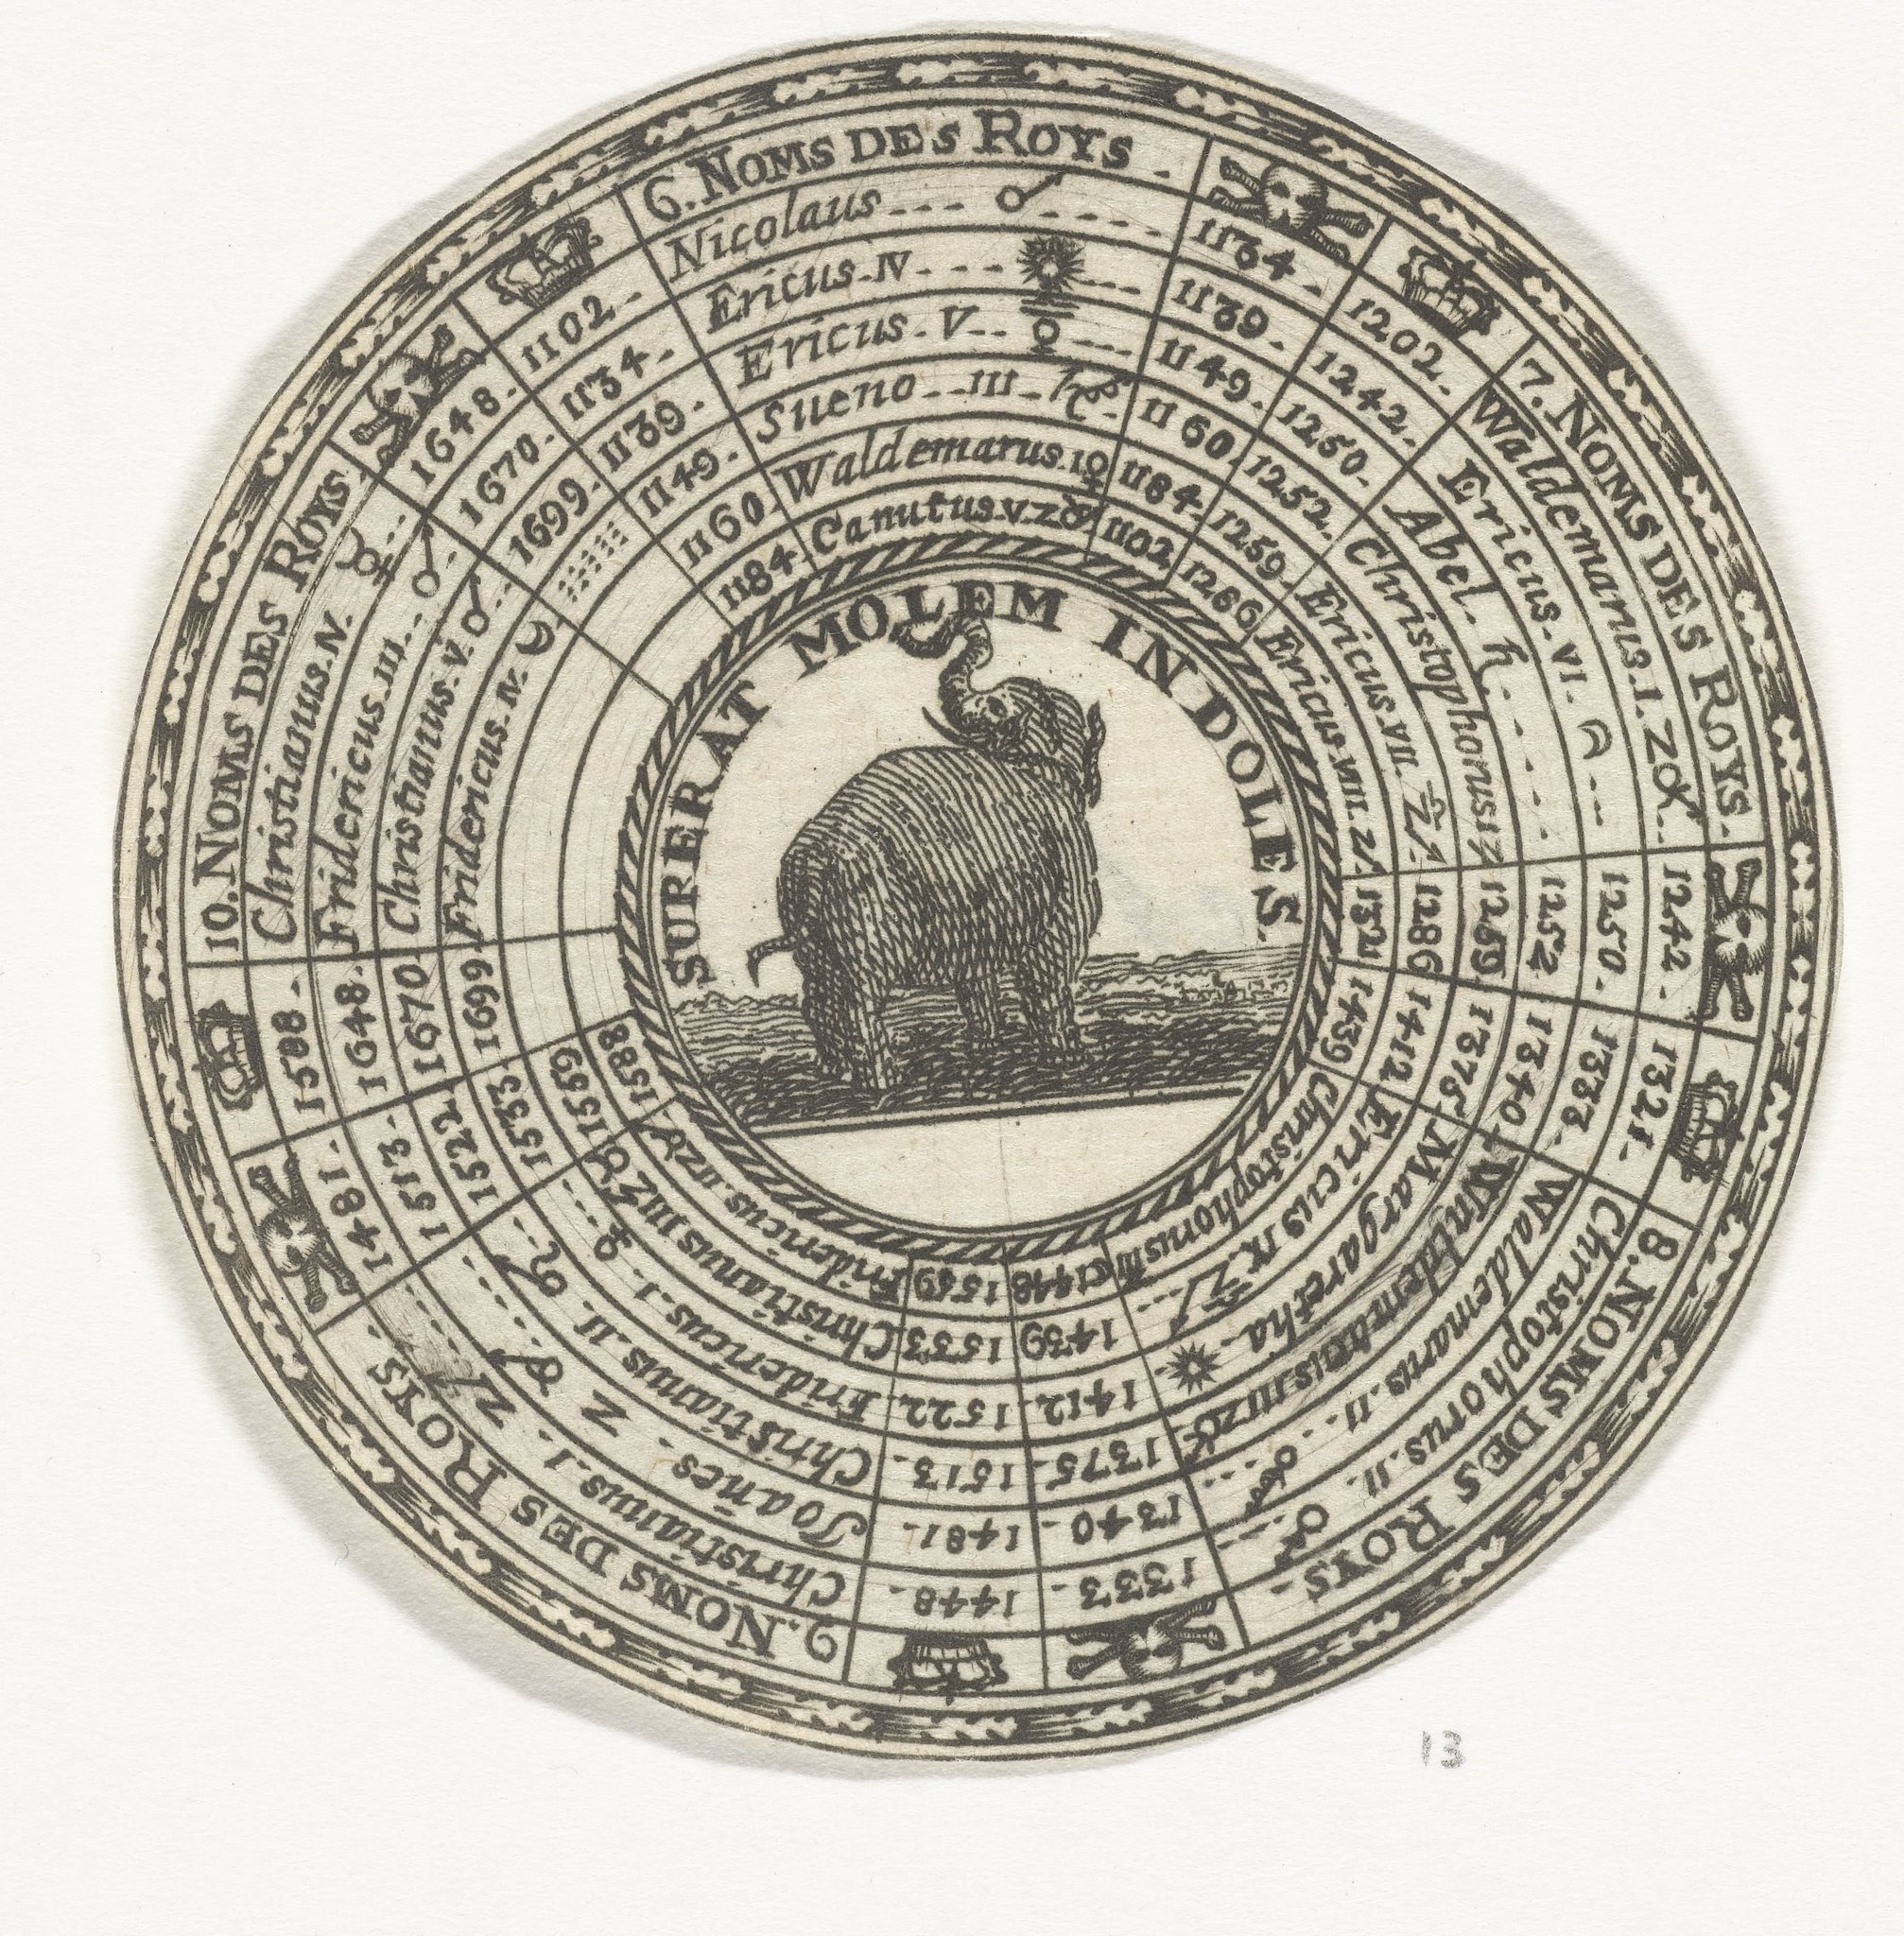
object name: print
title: Penning met een embleem en de namen van Deense koningen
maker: Anonymous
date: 1685-1720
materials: paper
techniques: etching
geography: amsterdam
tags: copenhagen (city), frederik iv (koning van denemarken en noorwegen), device (as symbol of the state, etc.), abstract ideas and concepts (+ emblematical representation of concept), king, seal (symbol of sovereignty), trunked animals: elephant (+ animals used symbolically)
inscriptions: number: ‘14’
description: Ontwerp van een ronde penning met, in zeven concentrische cirkels, de namen van Deense koningen en hun regeringsjaren, beginnende bij koning Nicolaas en eindigend bij koning koning Frederik IV. In het midden van de penning een embleem met een olifant en het motto: "Superat Molem Indoles".